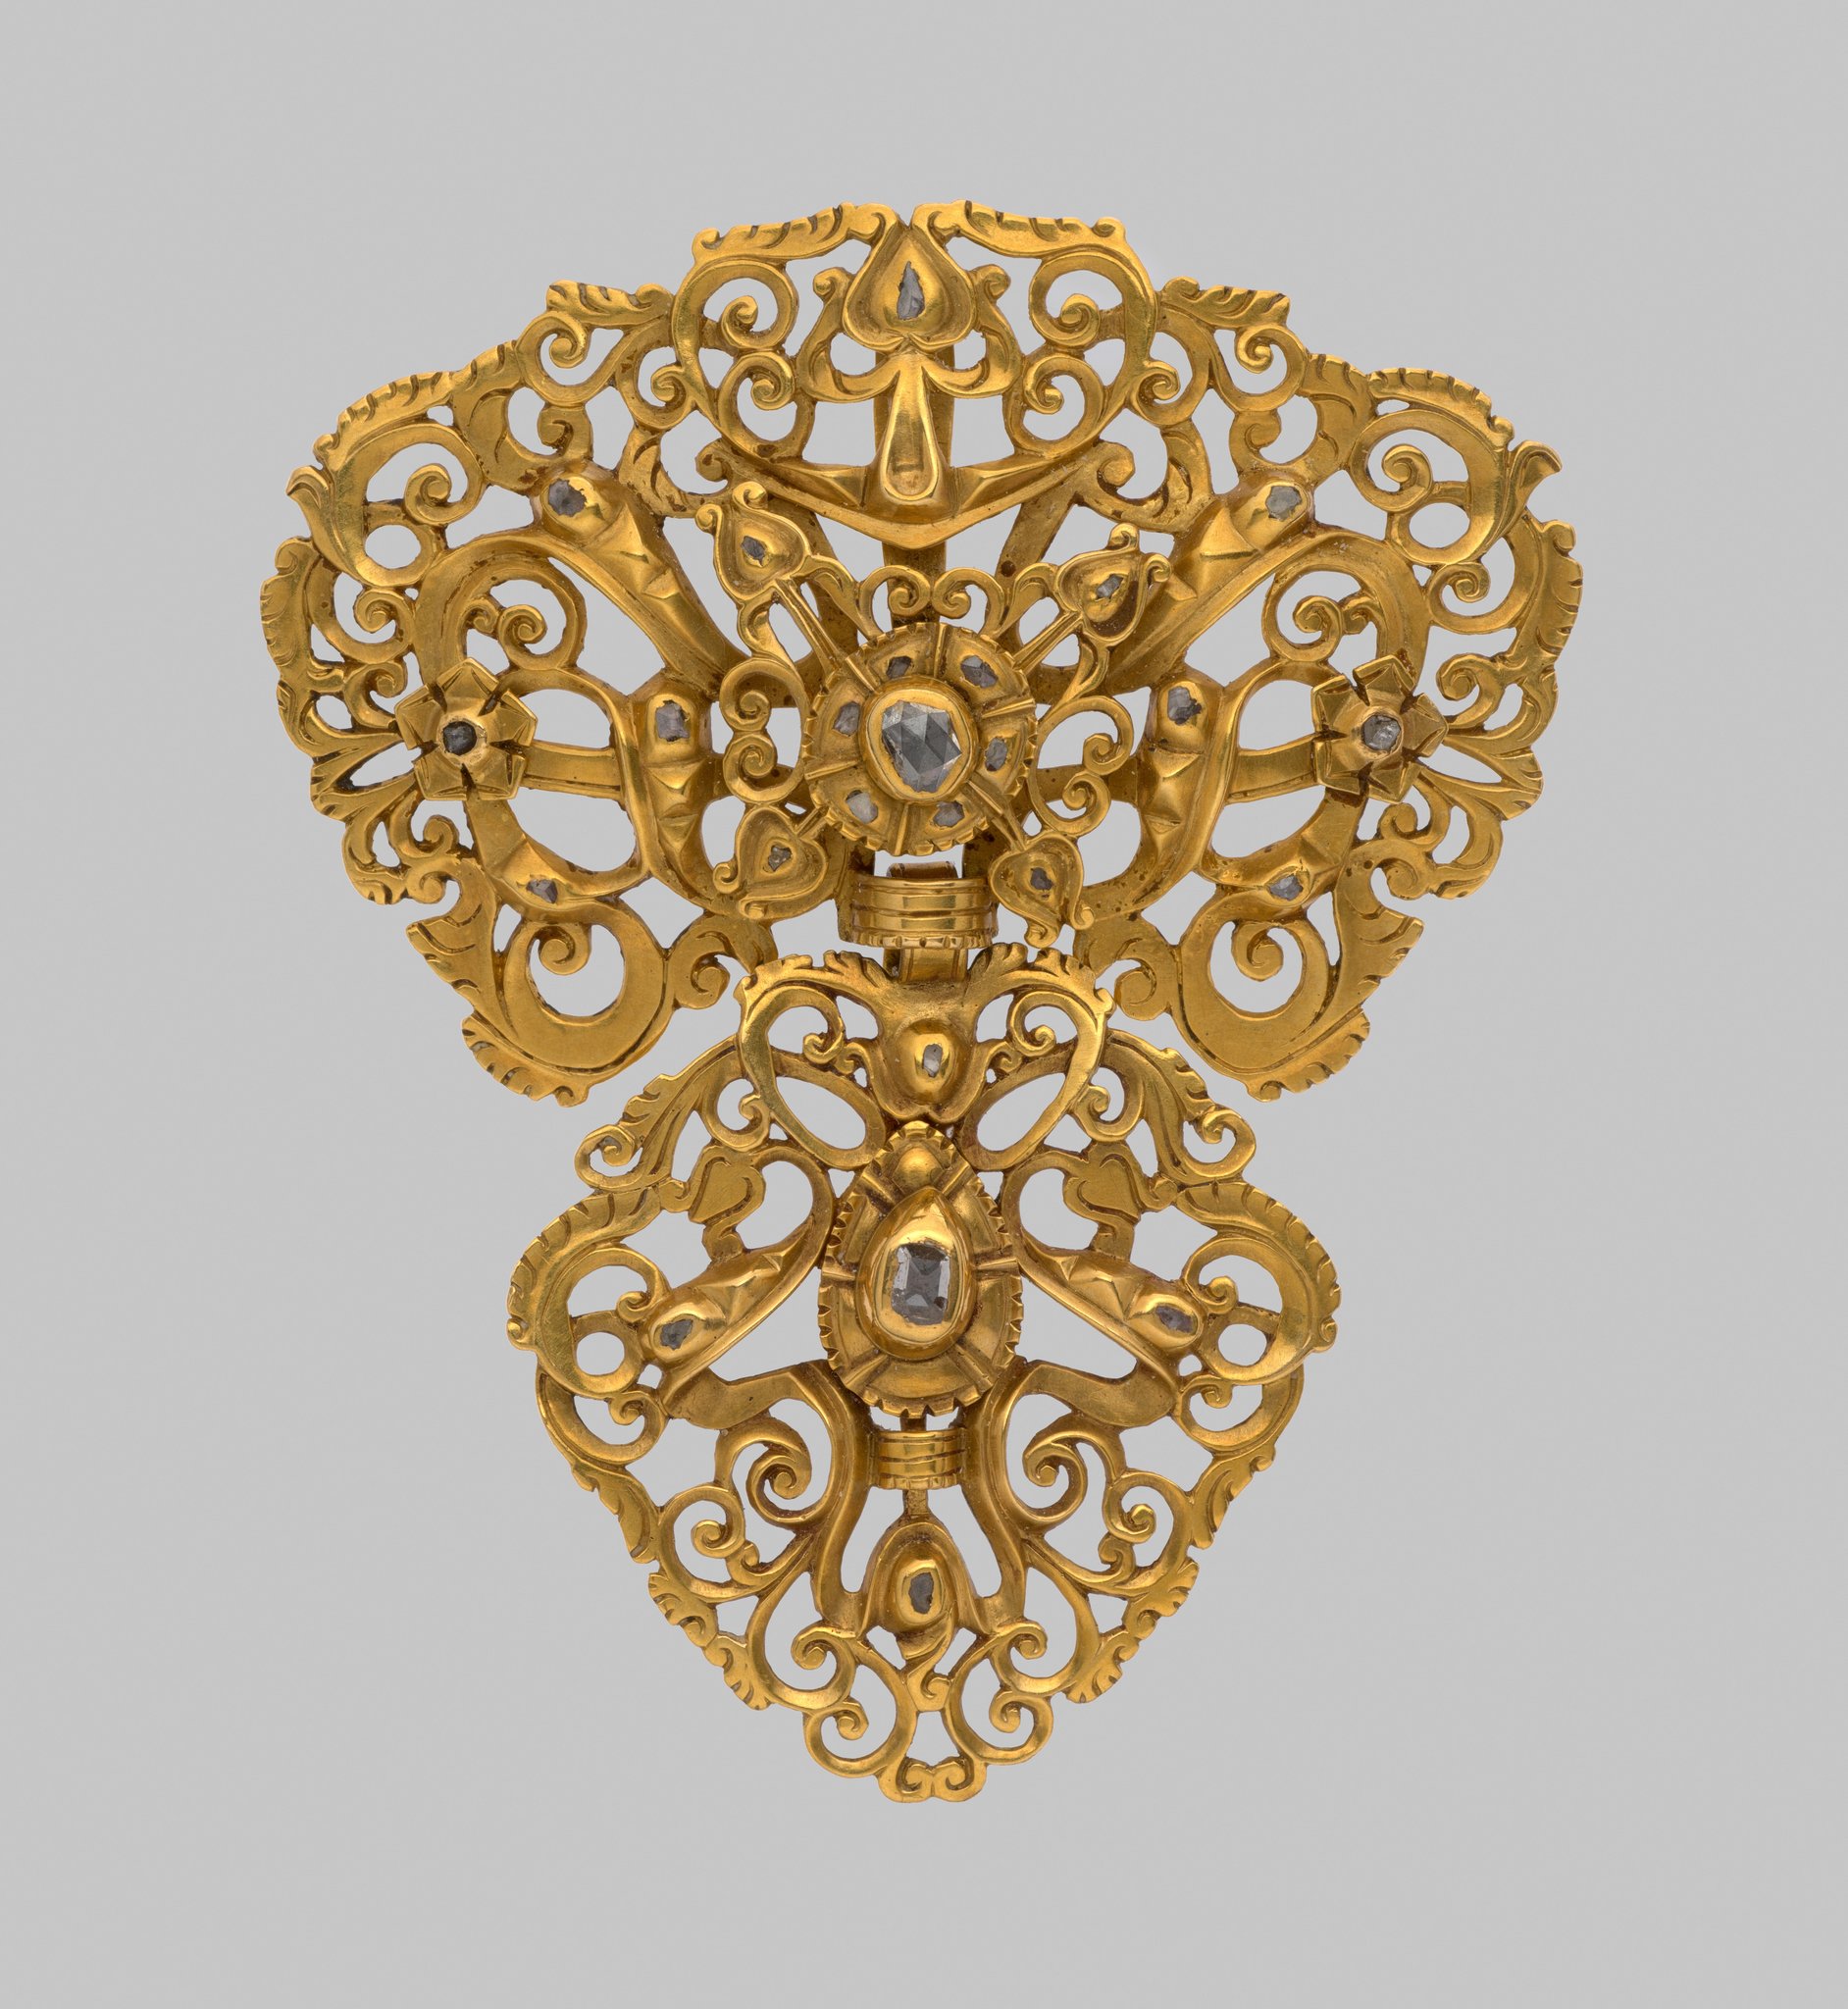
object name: pendant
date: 1801-1900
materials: diamond, gold